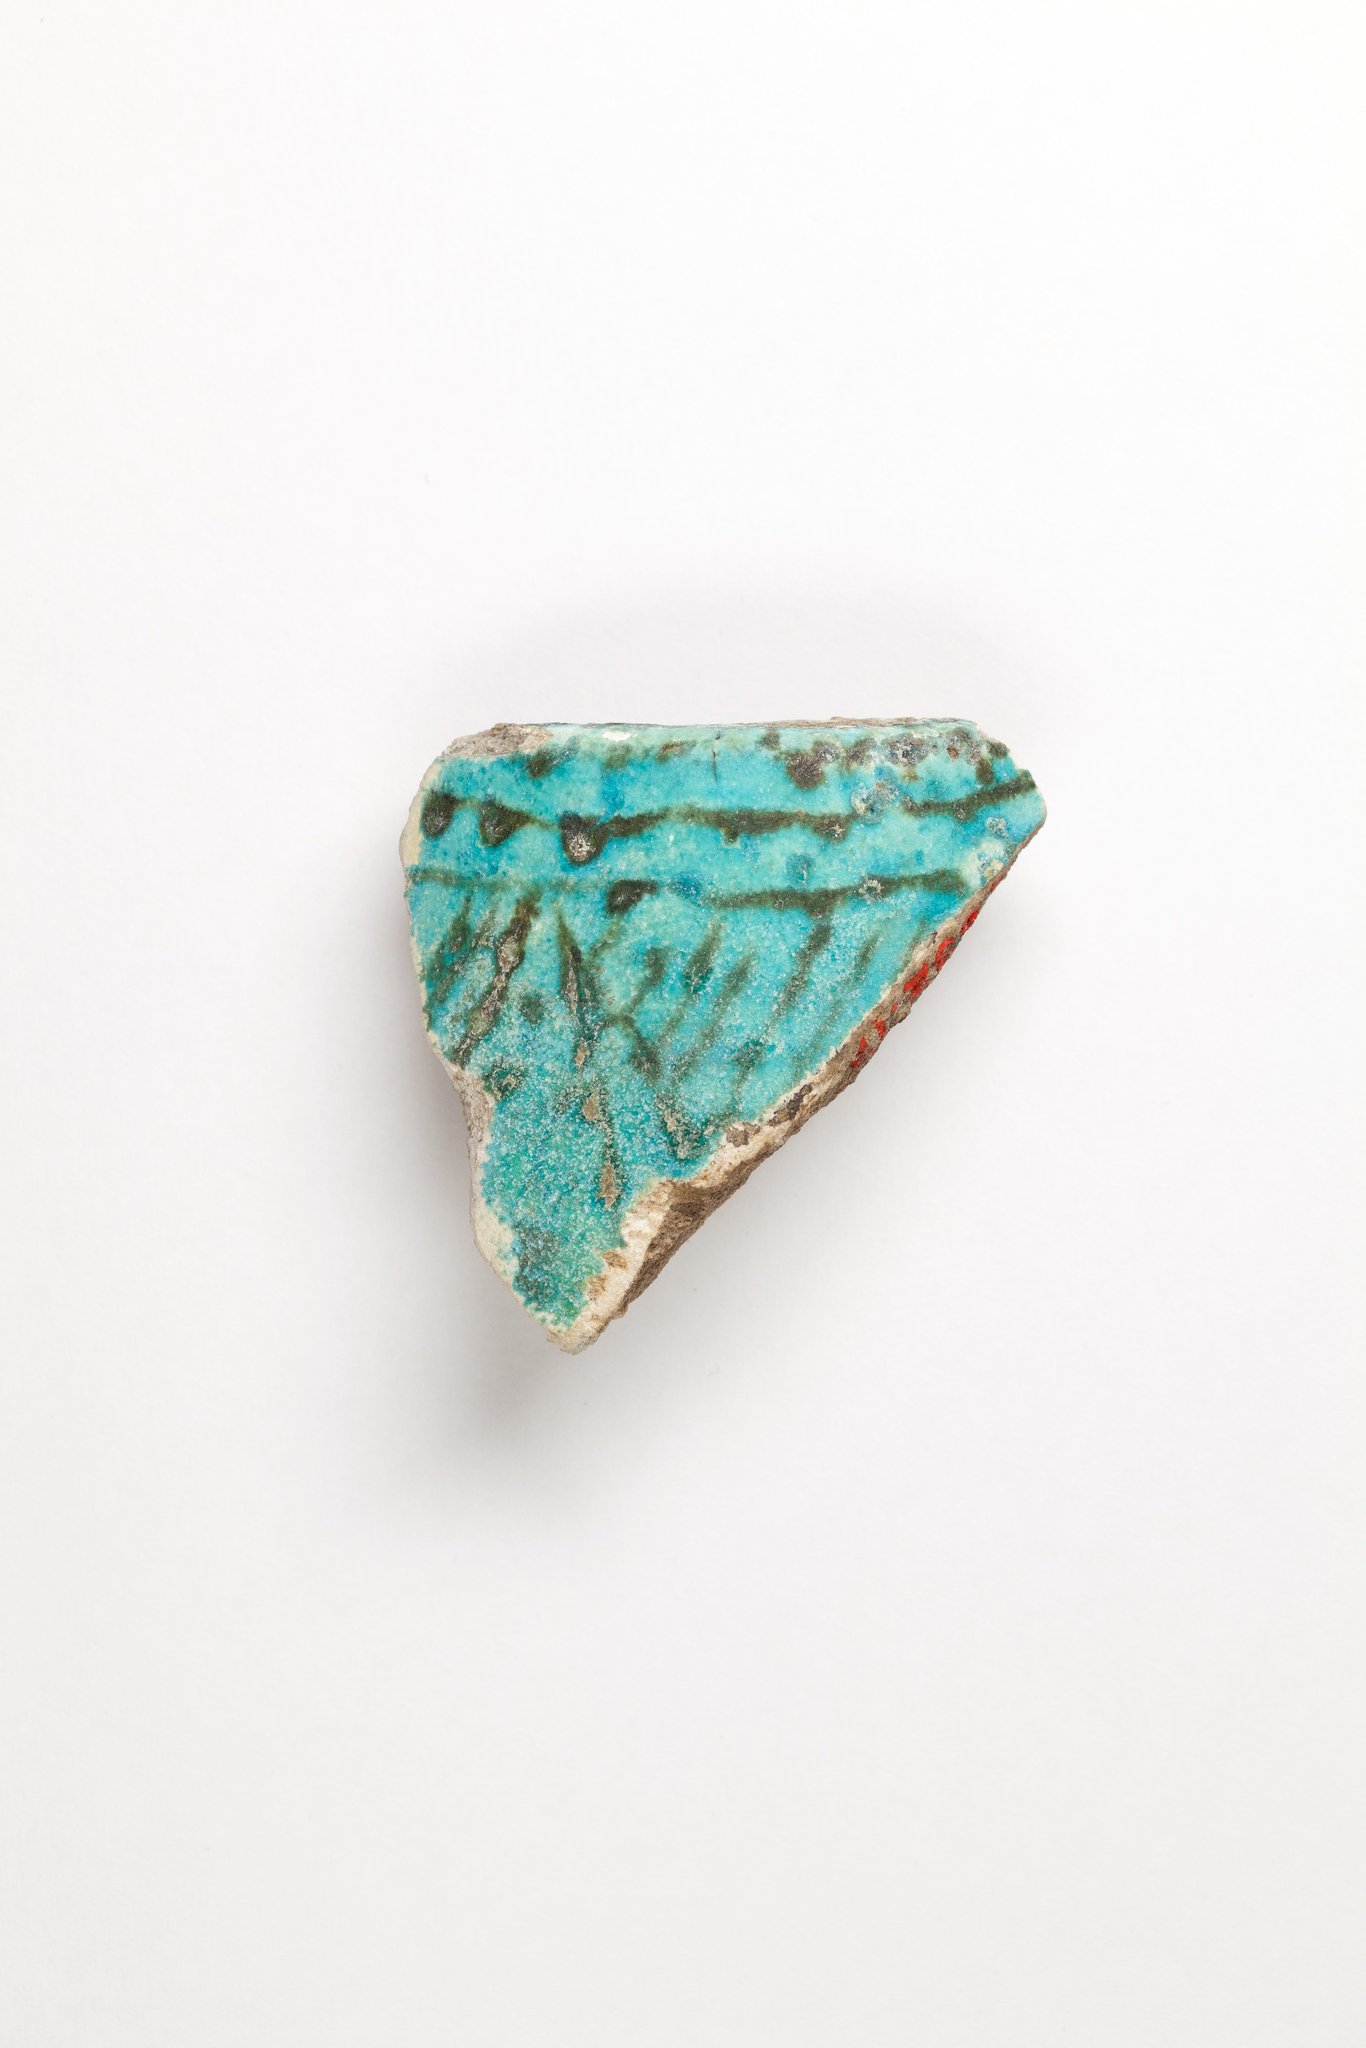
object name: vase fragment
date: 1981-1640 BCE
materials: faience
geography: egypt